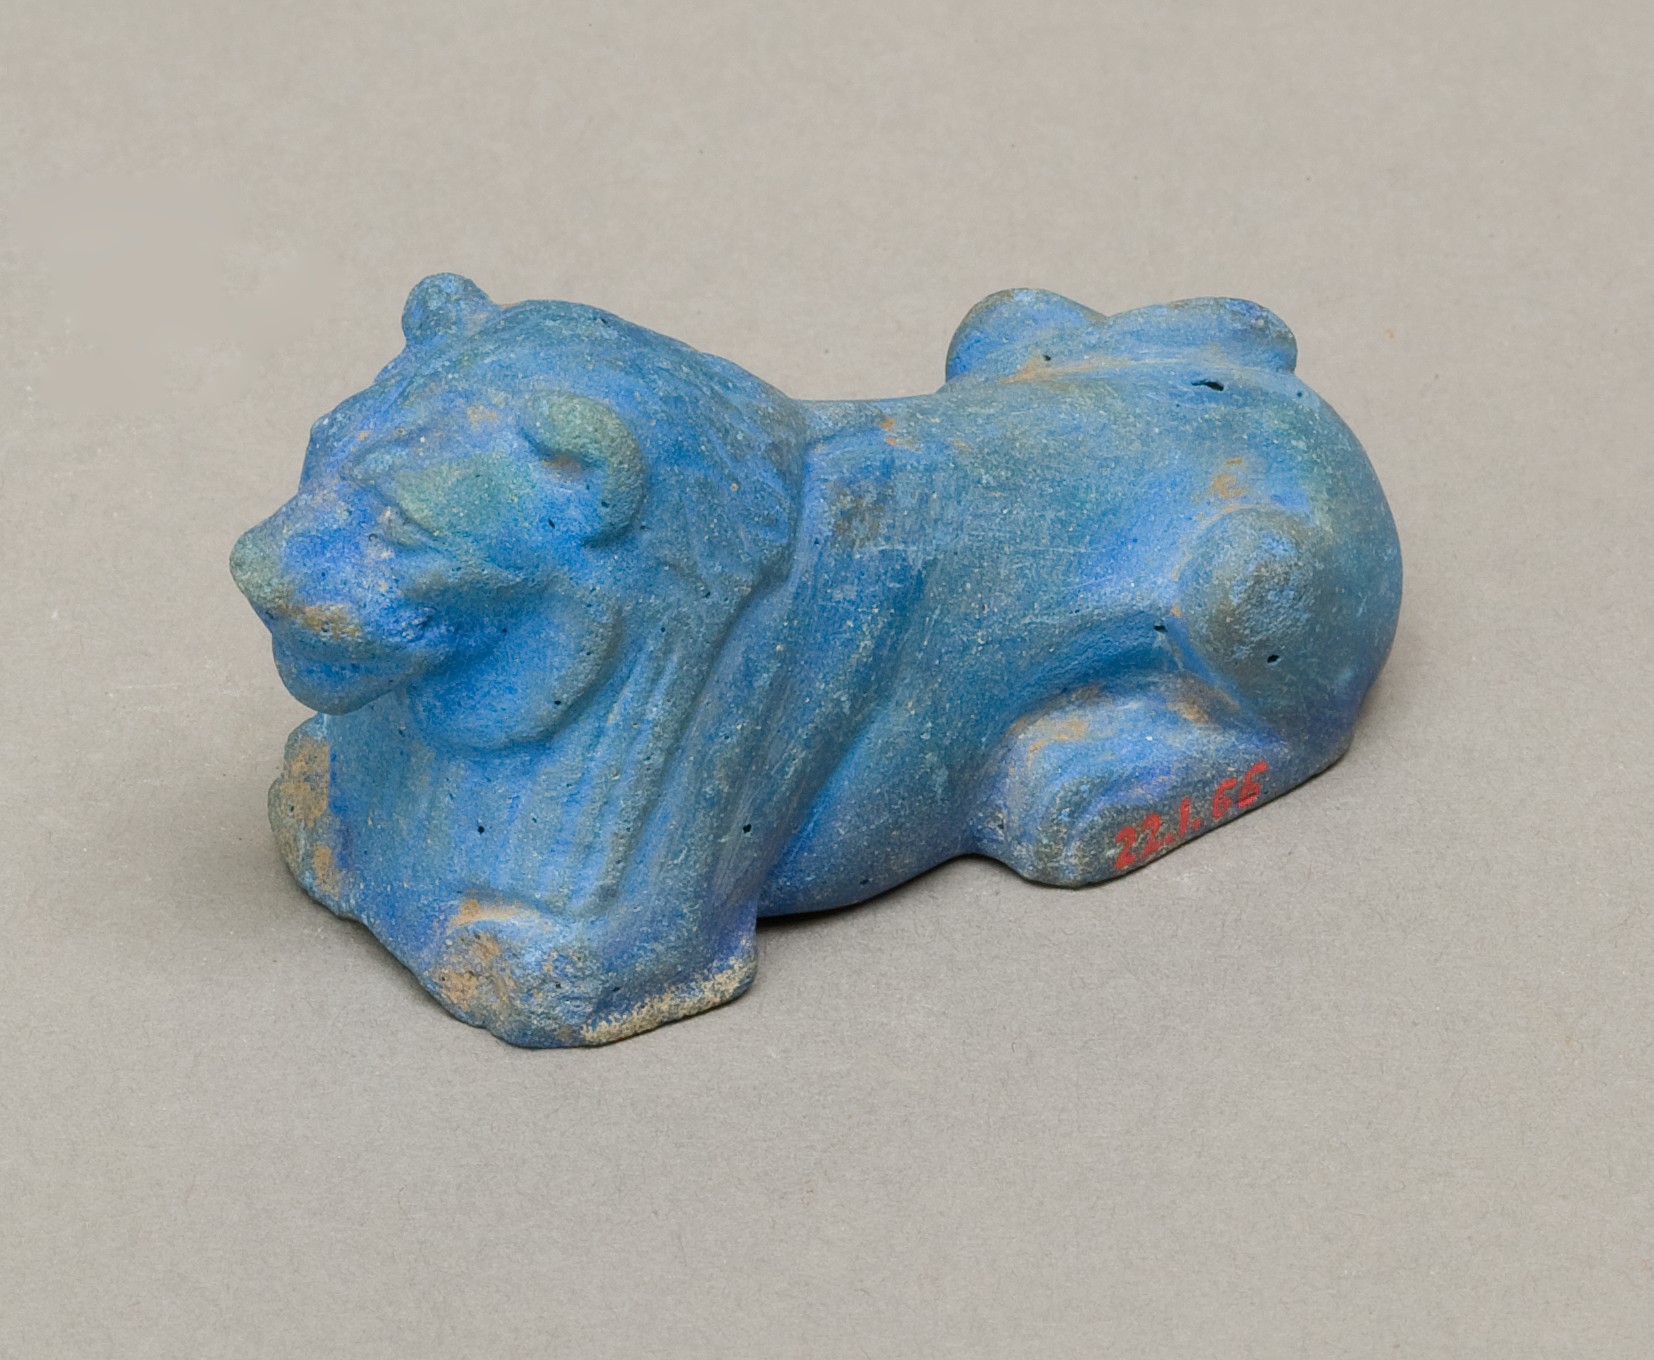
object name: figurine, lion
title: Figure of lion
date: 1981-1640 BCE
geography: egypt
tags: lions